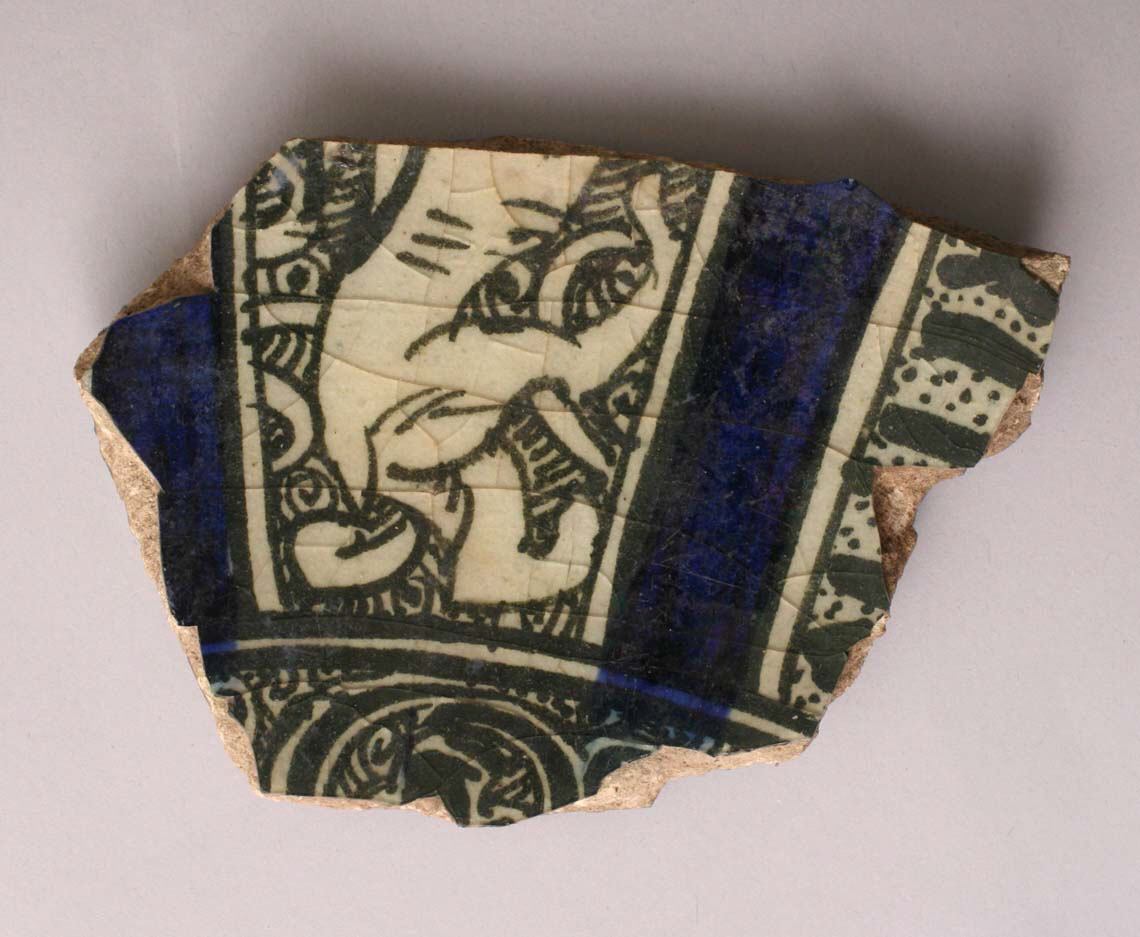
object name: ceramic fragment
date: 1301-1400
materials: glaze, stonepaste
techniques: painting, polychrome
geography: egypt or syria